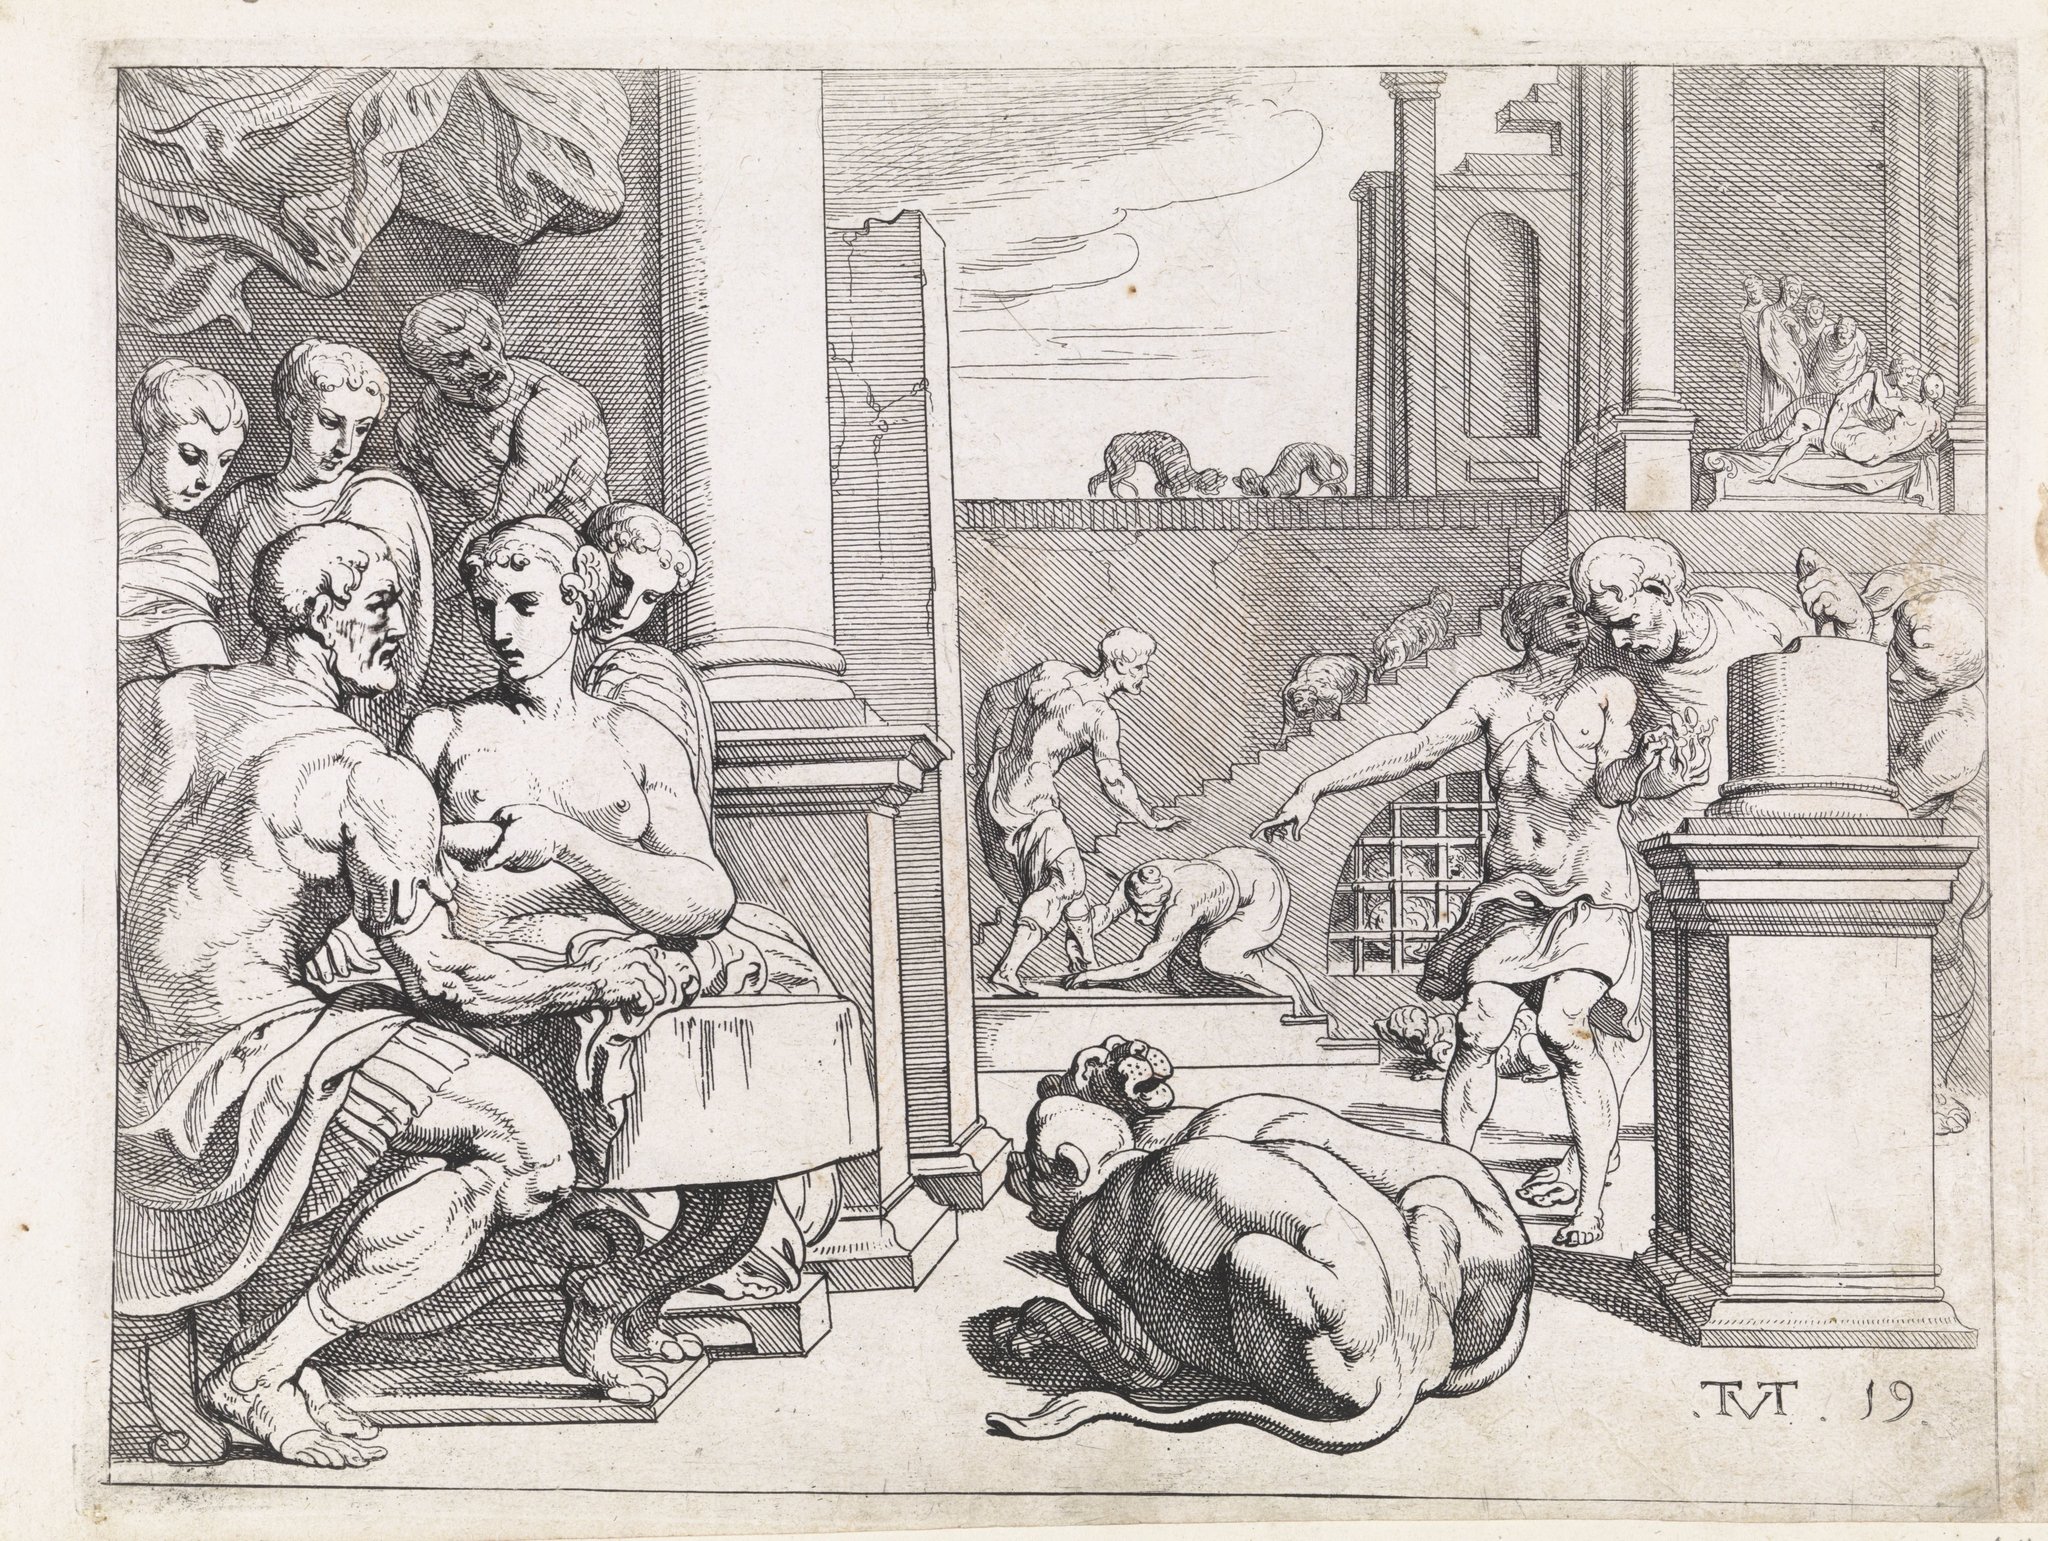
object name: print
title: Odysseus in het paleis van Circe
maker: theodoor van thulden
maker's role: draughtsman, painter, print maker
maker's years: 1606-1669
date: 1632-1633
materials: paper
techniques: engraving, etching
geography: paris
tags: mercury gives ulysses the magic herb 'moly', a countercharm, ulysses' companions are changed into all kinds of animals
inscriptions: collector's mark: Lugt 2228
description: Odysseus in het paleis van Circe. Rechts biedt Mercurius aan Odysseus een kruid aan dat werkt als tegengif tegen de toverdrank van Circe. Odysseus eet het op en gaat naar Circe. Daar zijn de mannen van Odysseus verandert in dieren en zwijnen omdat ze van de toverdrank hebben gedronken. Links op de voorgrond biedt Circe de toverdrank aan aan Odysseus. De drank heeft geen effect op hem en hij vraagt haar om zijn mannen hun menselijke gestalte terug te geven. Circe willigt dit verzoek in, maar vraagt Odysseus om eerst met haar naar bed te gaan. Dit gebeurt in de rechter bovenhoek.